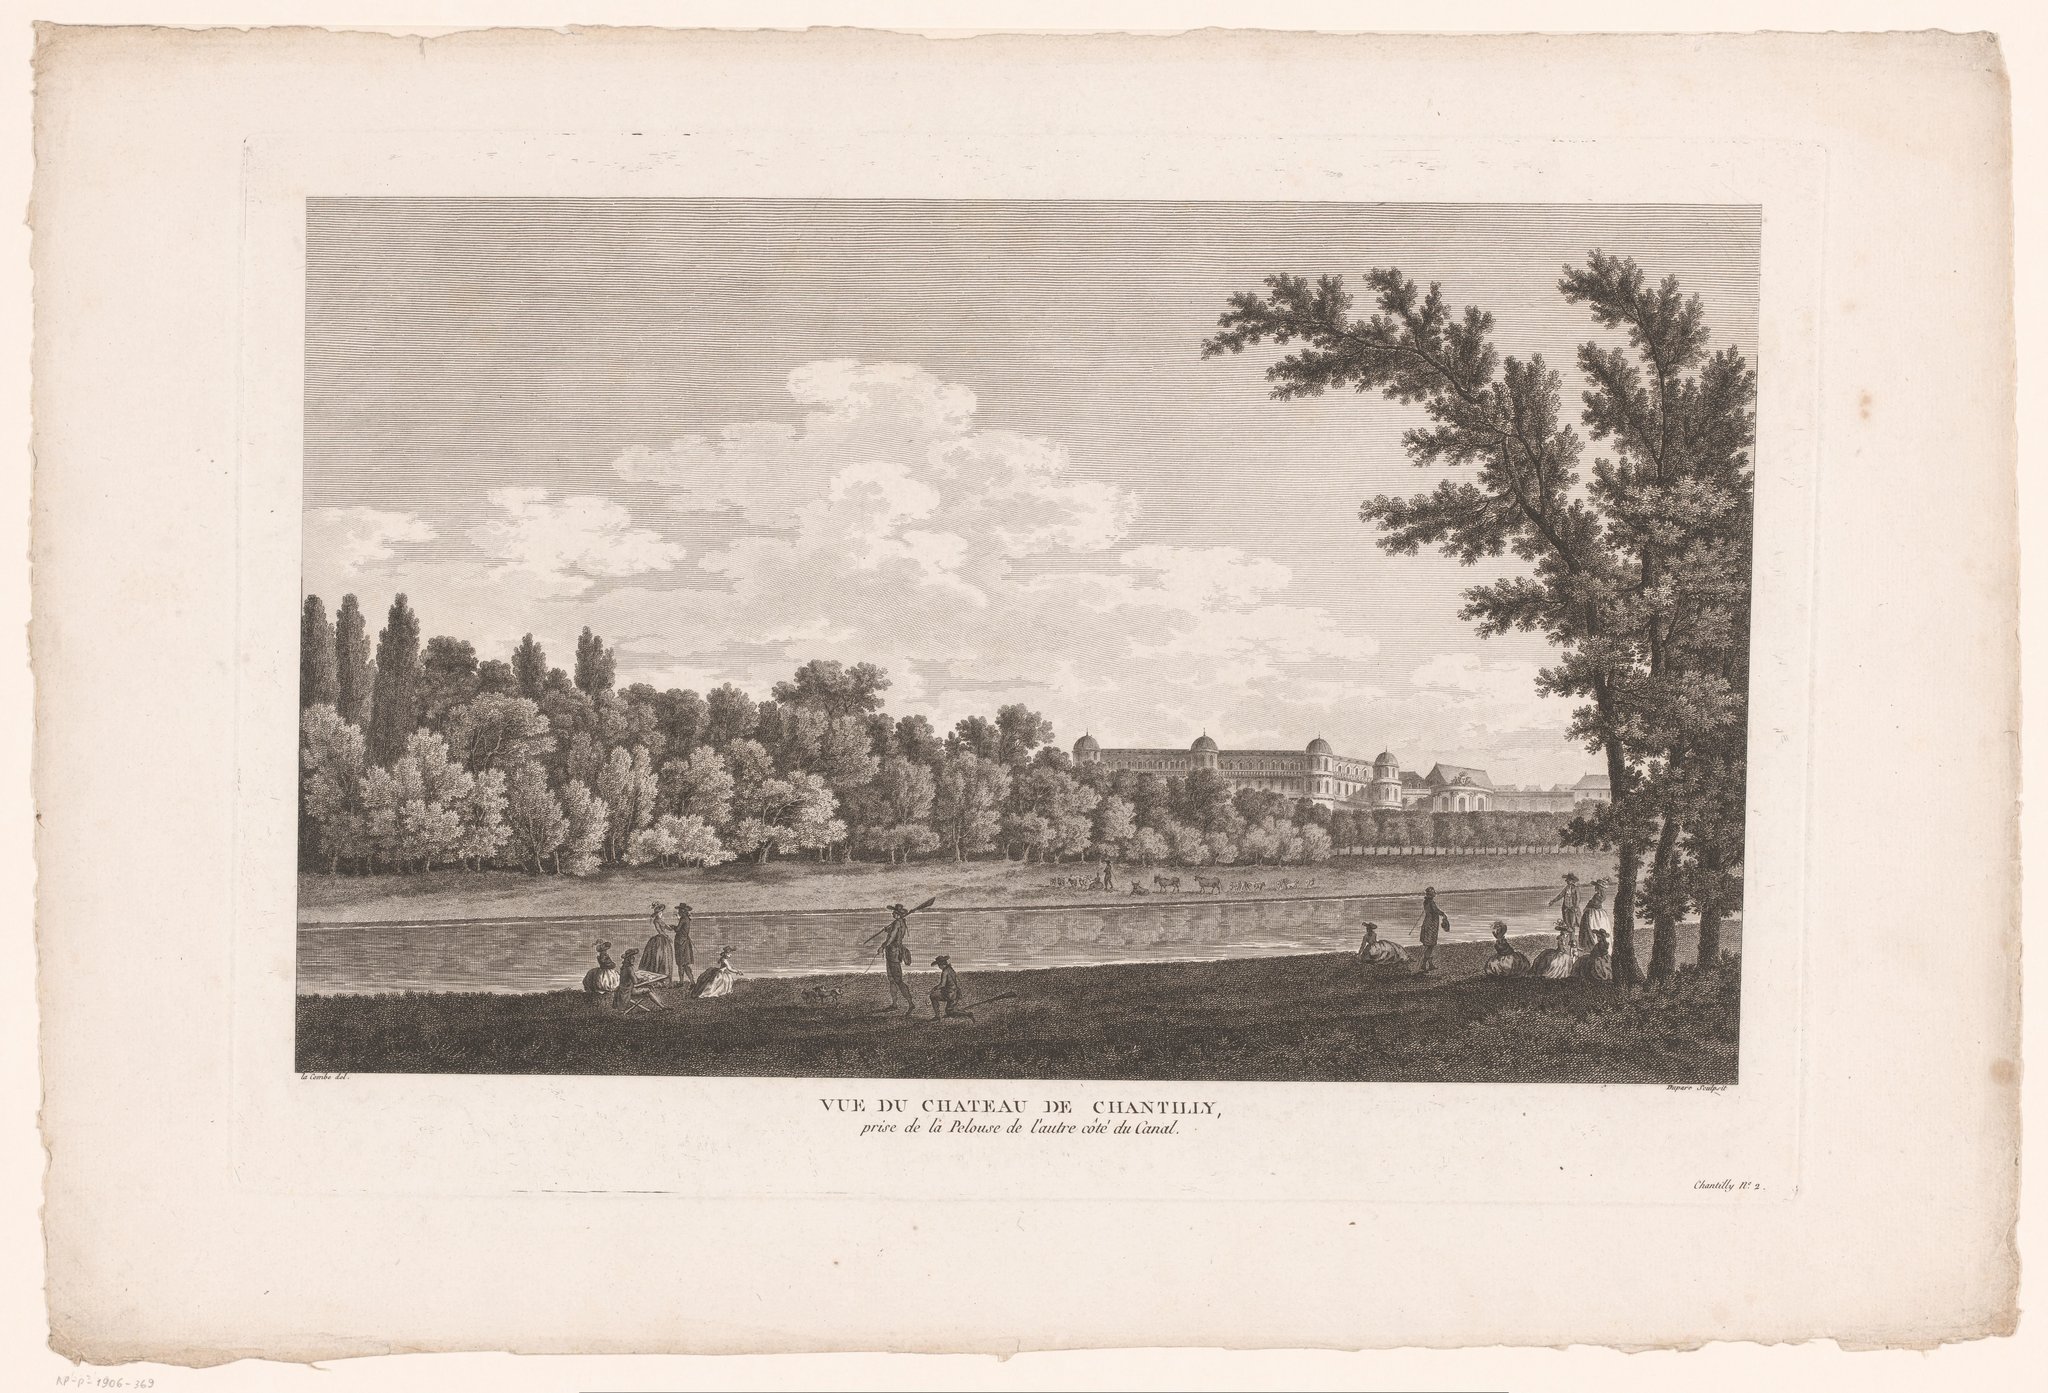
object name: print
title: Zicht op kasteel van Chantilly aan het kanaal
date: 1765-1830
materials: paper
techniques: etching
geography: paris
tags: castle, canal, chantilly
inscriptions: watermark, collector's mark: Lugt 2228